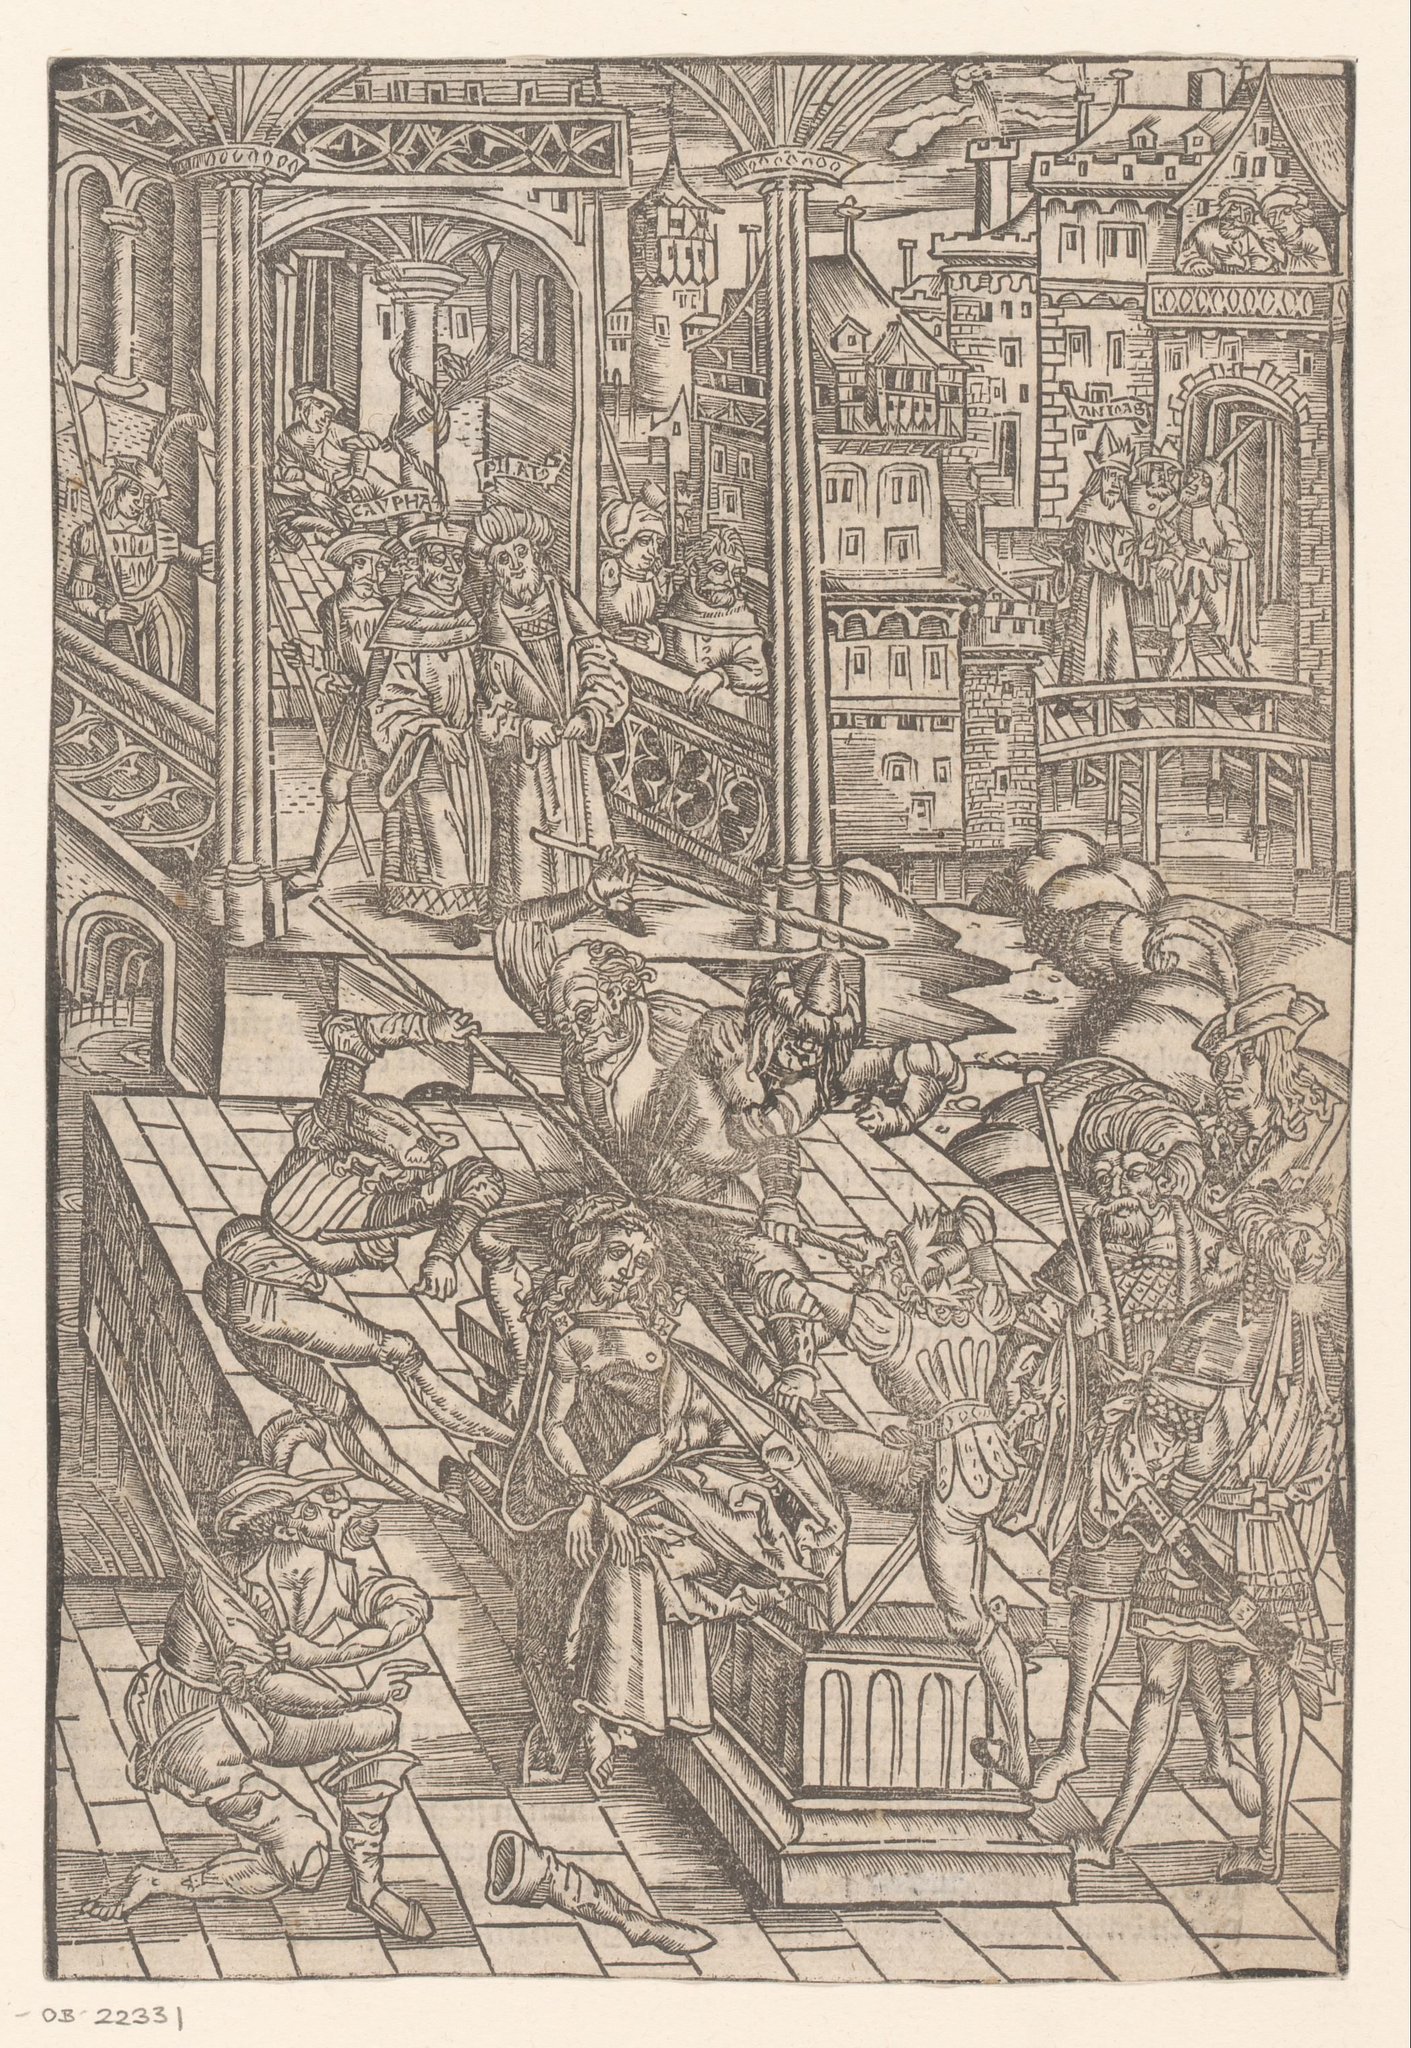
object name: book illustration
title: Doornenkroning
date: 1502-1510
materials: paper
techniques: woodcut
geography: straatsburg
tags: the crowning with thorns: soldiers with sticks place a thorny crown on christ's head and give him a reed (matthew 27:27-31; mark 15:16-20; john 19:2-3)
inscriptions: collector's mark: Lugt 240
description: Illustraties waarschijnlijk afkomstig uit: Der heilige leben (...). Straatsburg: Johann Grüninger, 1502 of 1510.